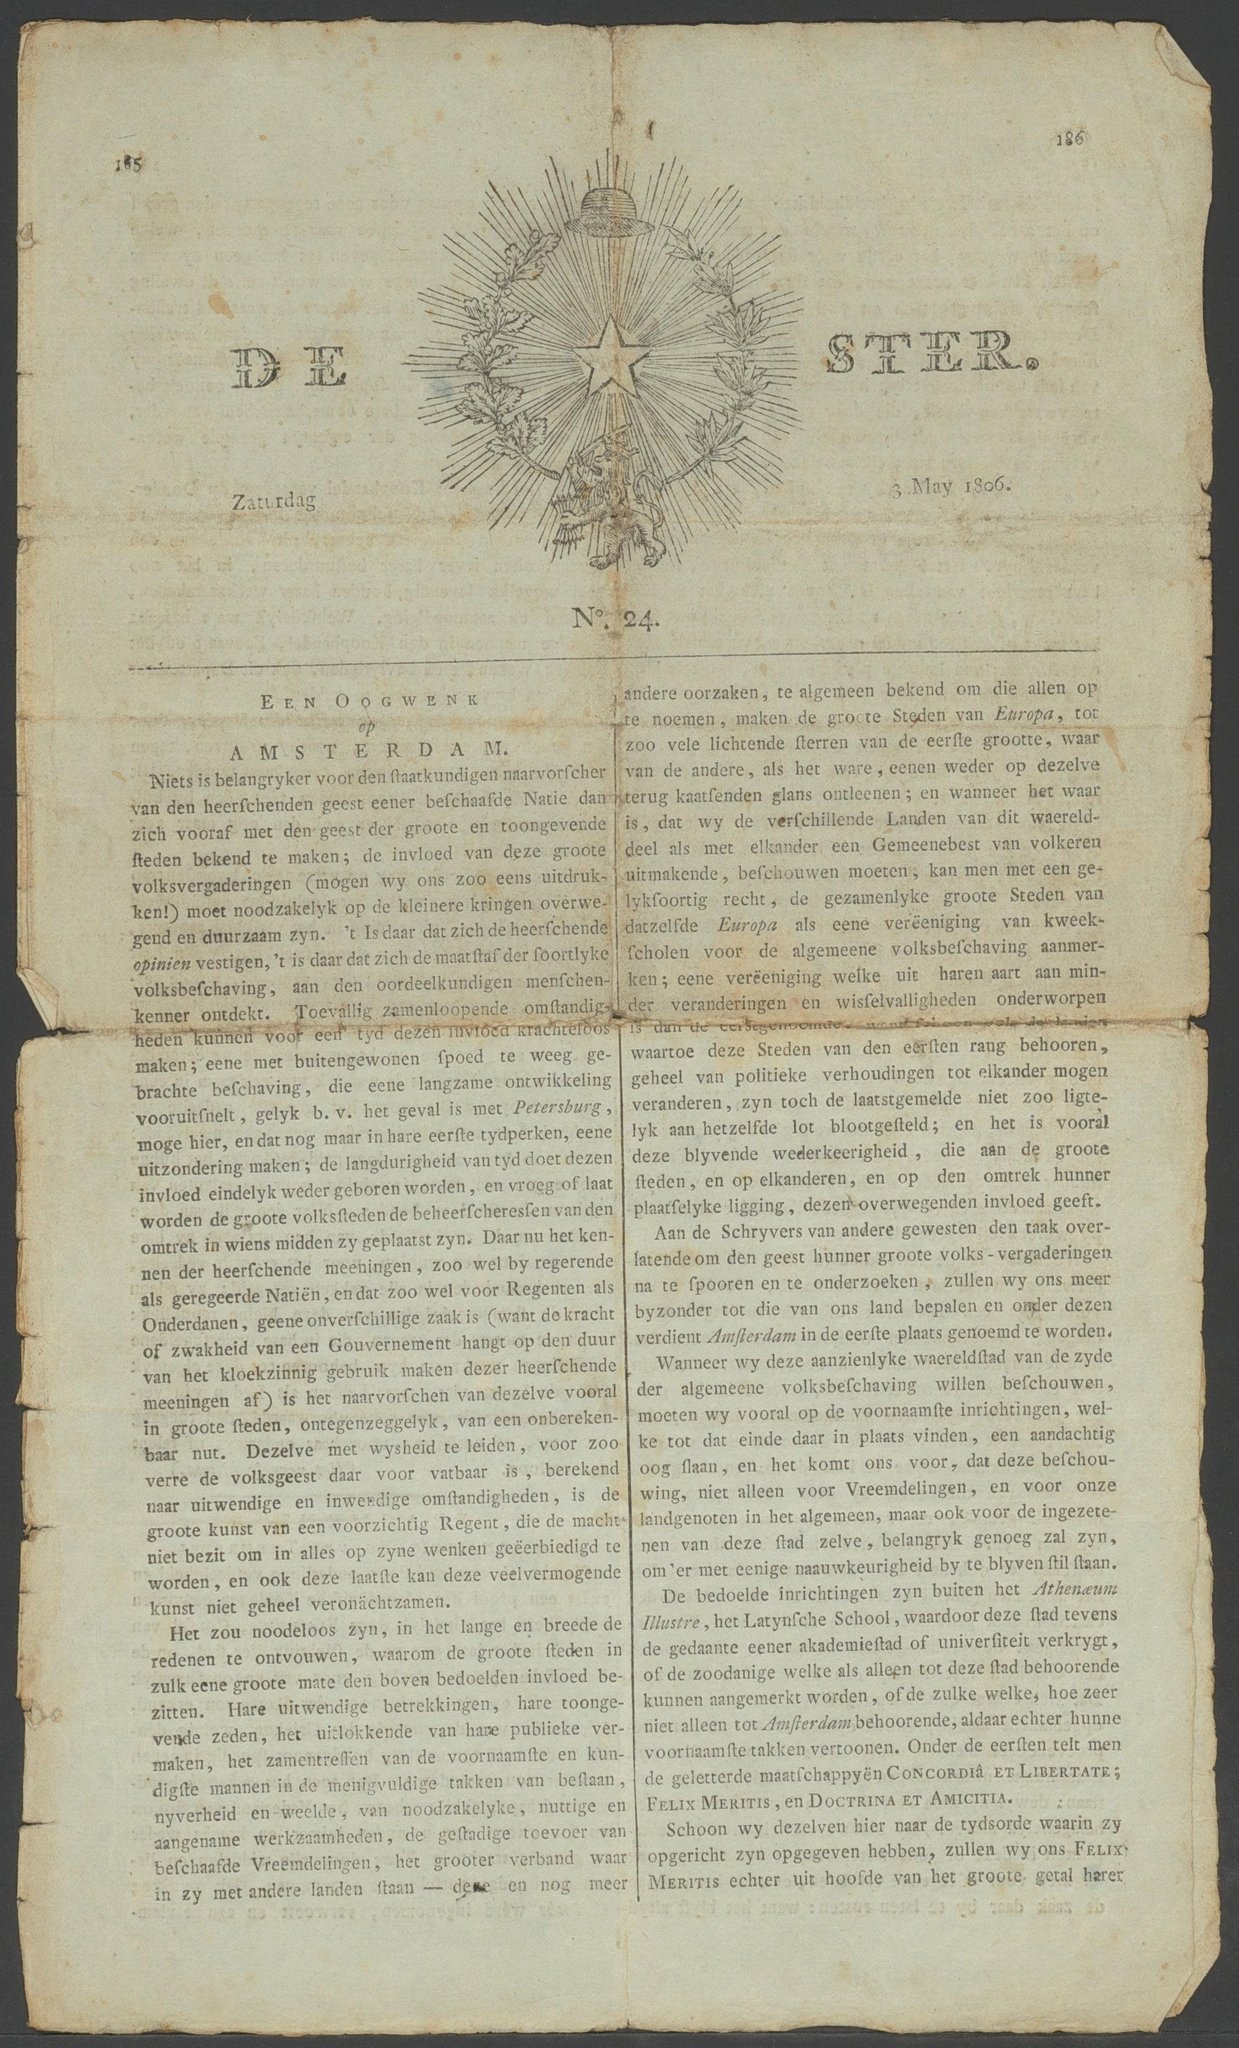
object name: newspaper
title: De Ster, 3 mei 1806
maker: j.g. rohloff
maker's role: printer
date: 1806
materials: paper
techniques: letterpress printing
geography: amsterdam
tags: newspaper, news-sheet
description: Exemplaar van de krant 'De Ster' van 3 mei 1806, nr. 24. Dubbelbladig, alle zijden bedrukt. De kolommen genummerd 185-192. Bovenaan een vignet met een stralende ster. Onderwerpsrubrieken binnen de Atlas Zeden en Gewoonten: Regeering, Officieele Nieuwsbladen.